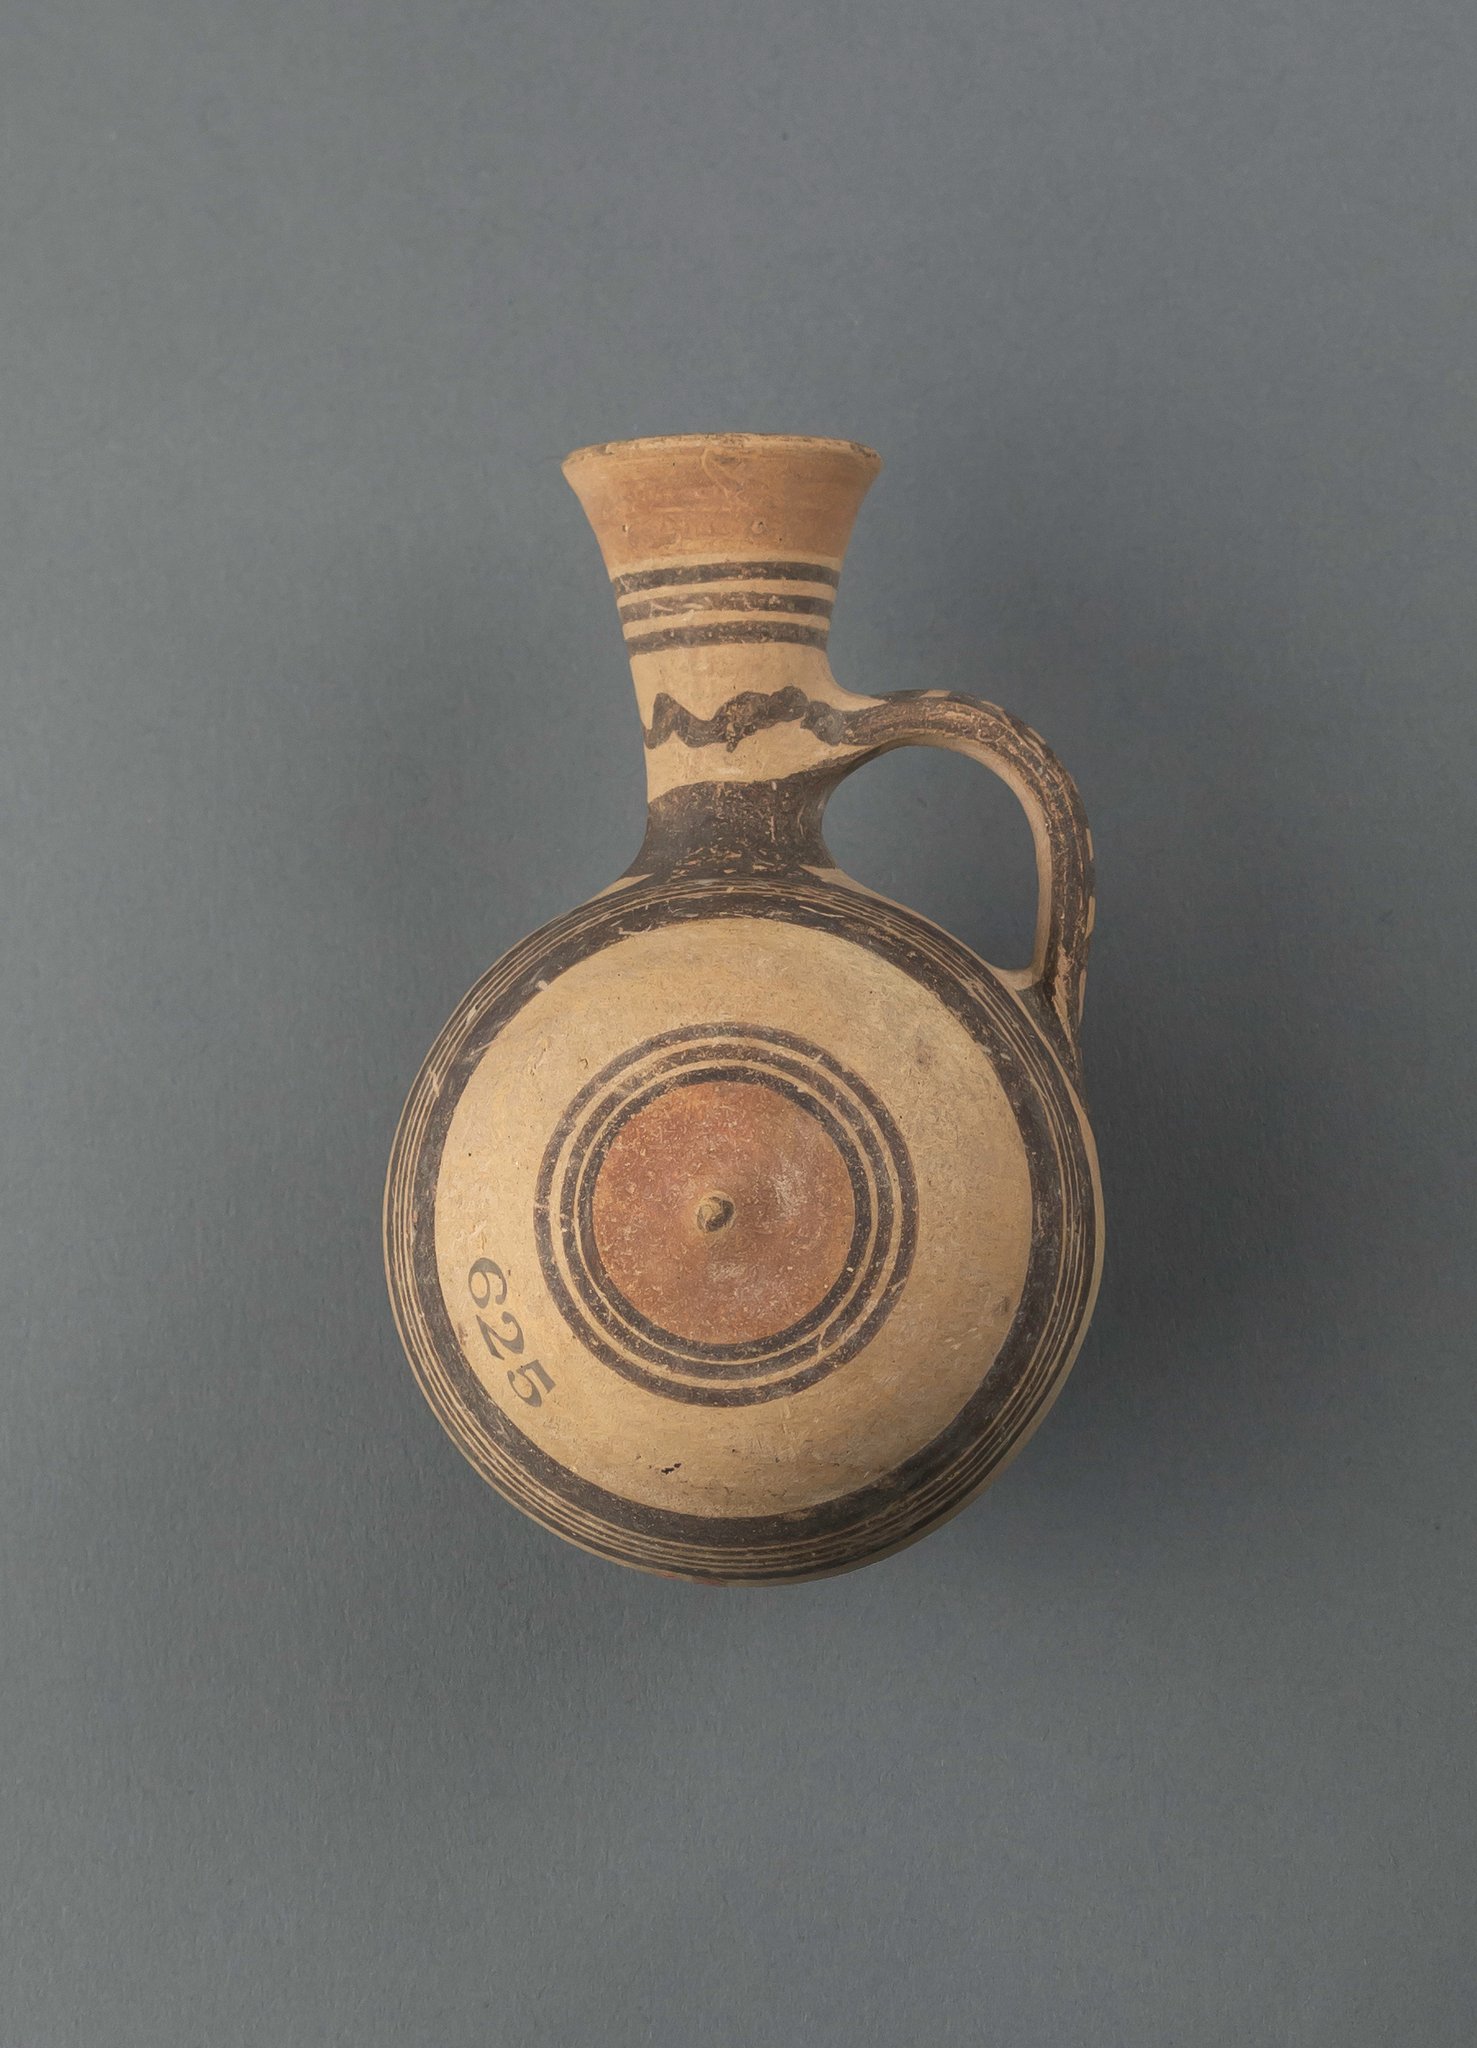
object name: juglet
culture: cypriot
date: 850-750 BCE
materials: terracotta